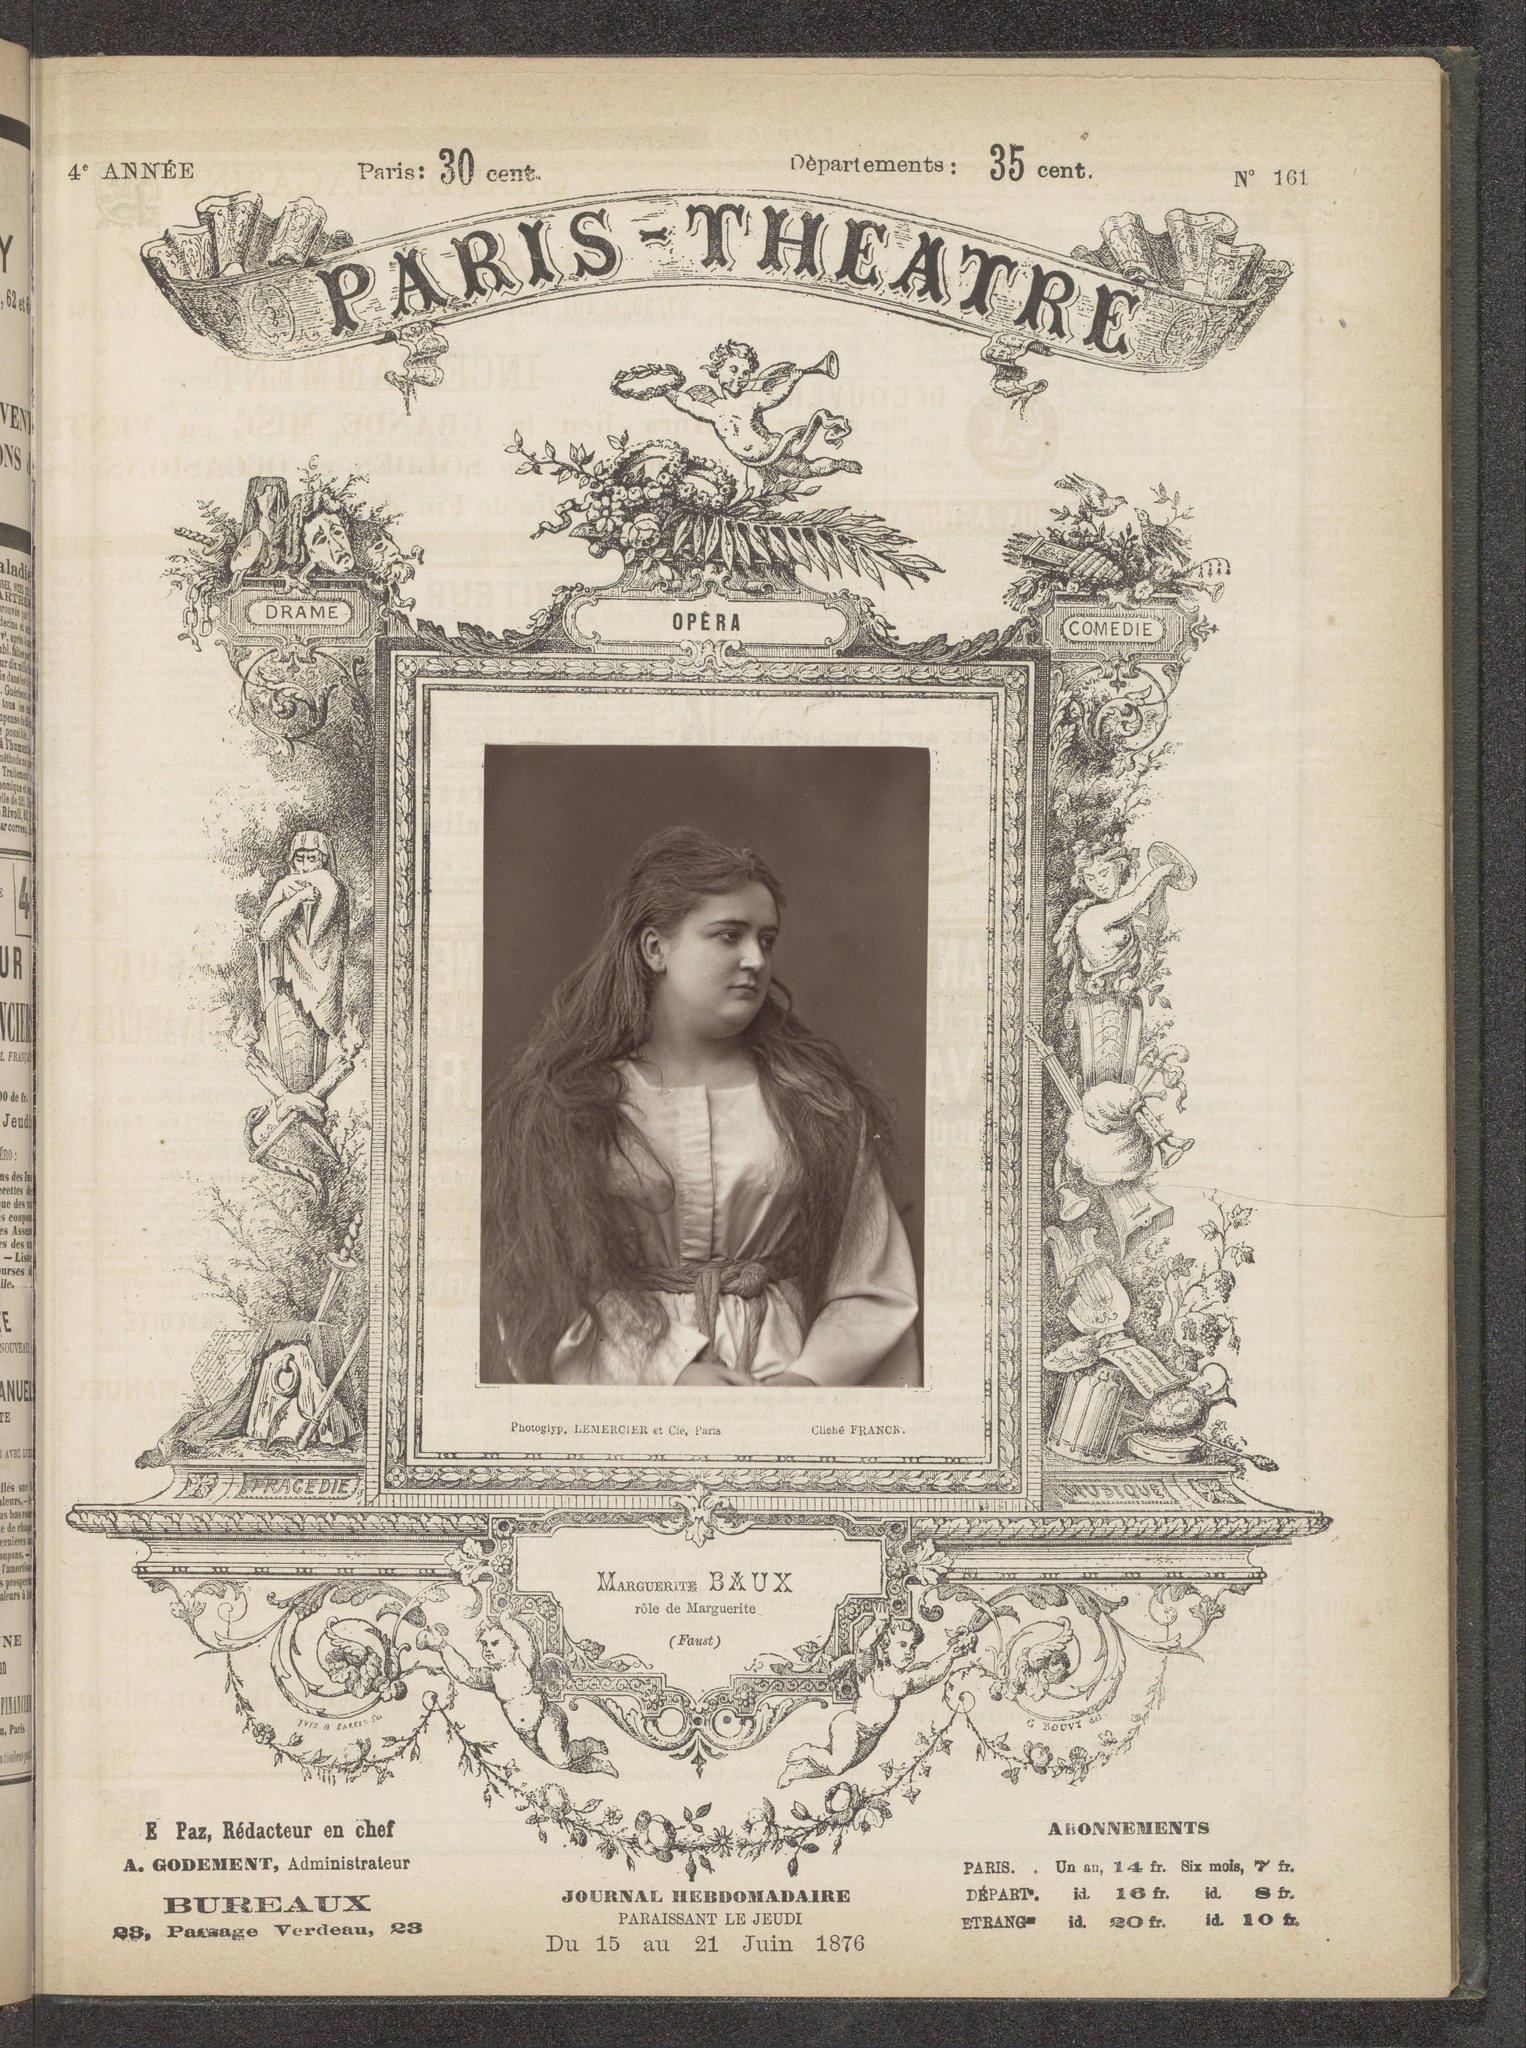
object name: photomechanical print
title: Marguerite Baux rôle de Marguerite (Faust)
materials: paper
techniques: woodburytype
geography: paris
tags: marseille, portrait of opera-singer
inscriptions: number: ‘No 161’, inscription: ‘Journal hebdomadaire paraissant le jeudi Du 15 au 21 Juin 1876’